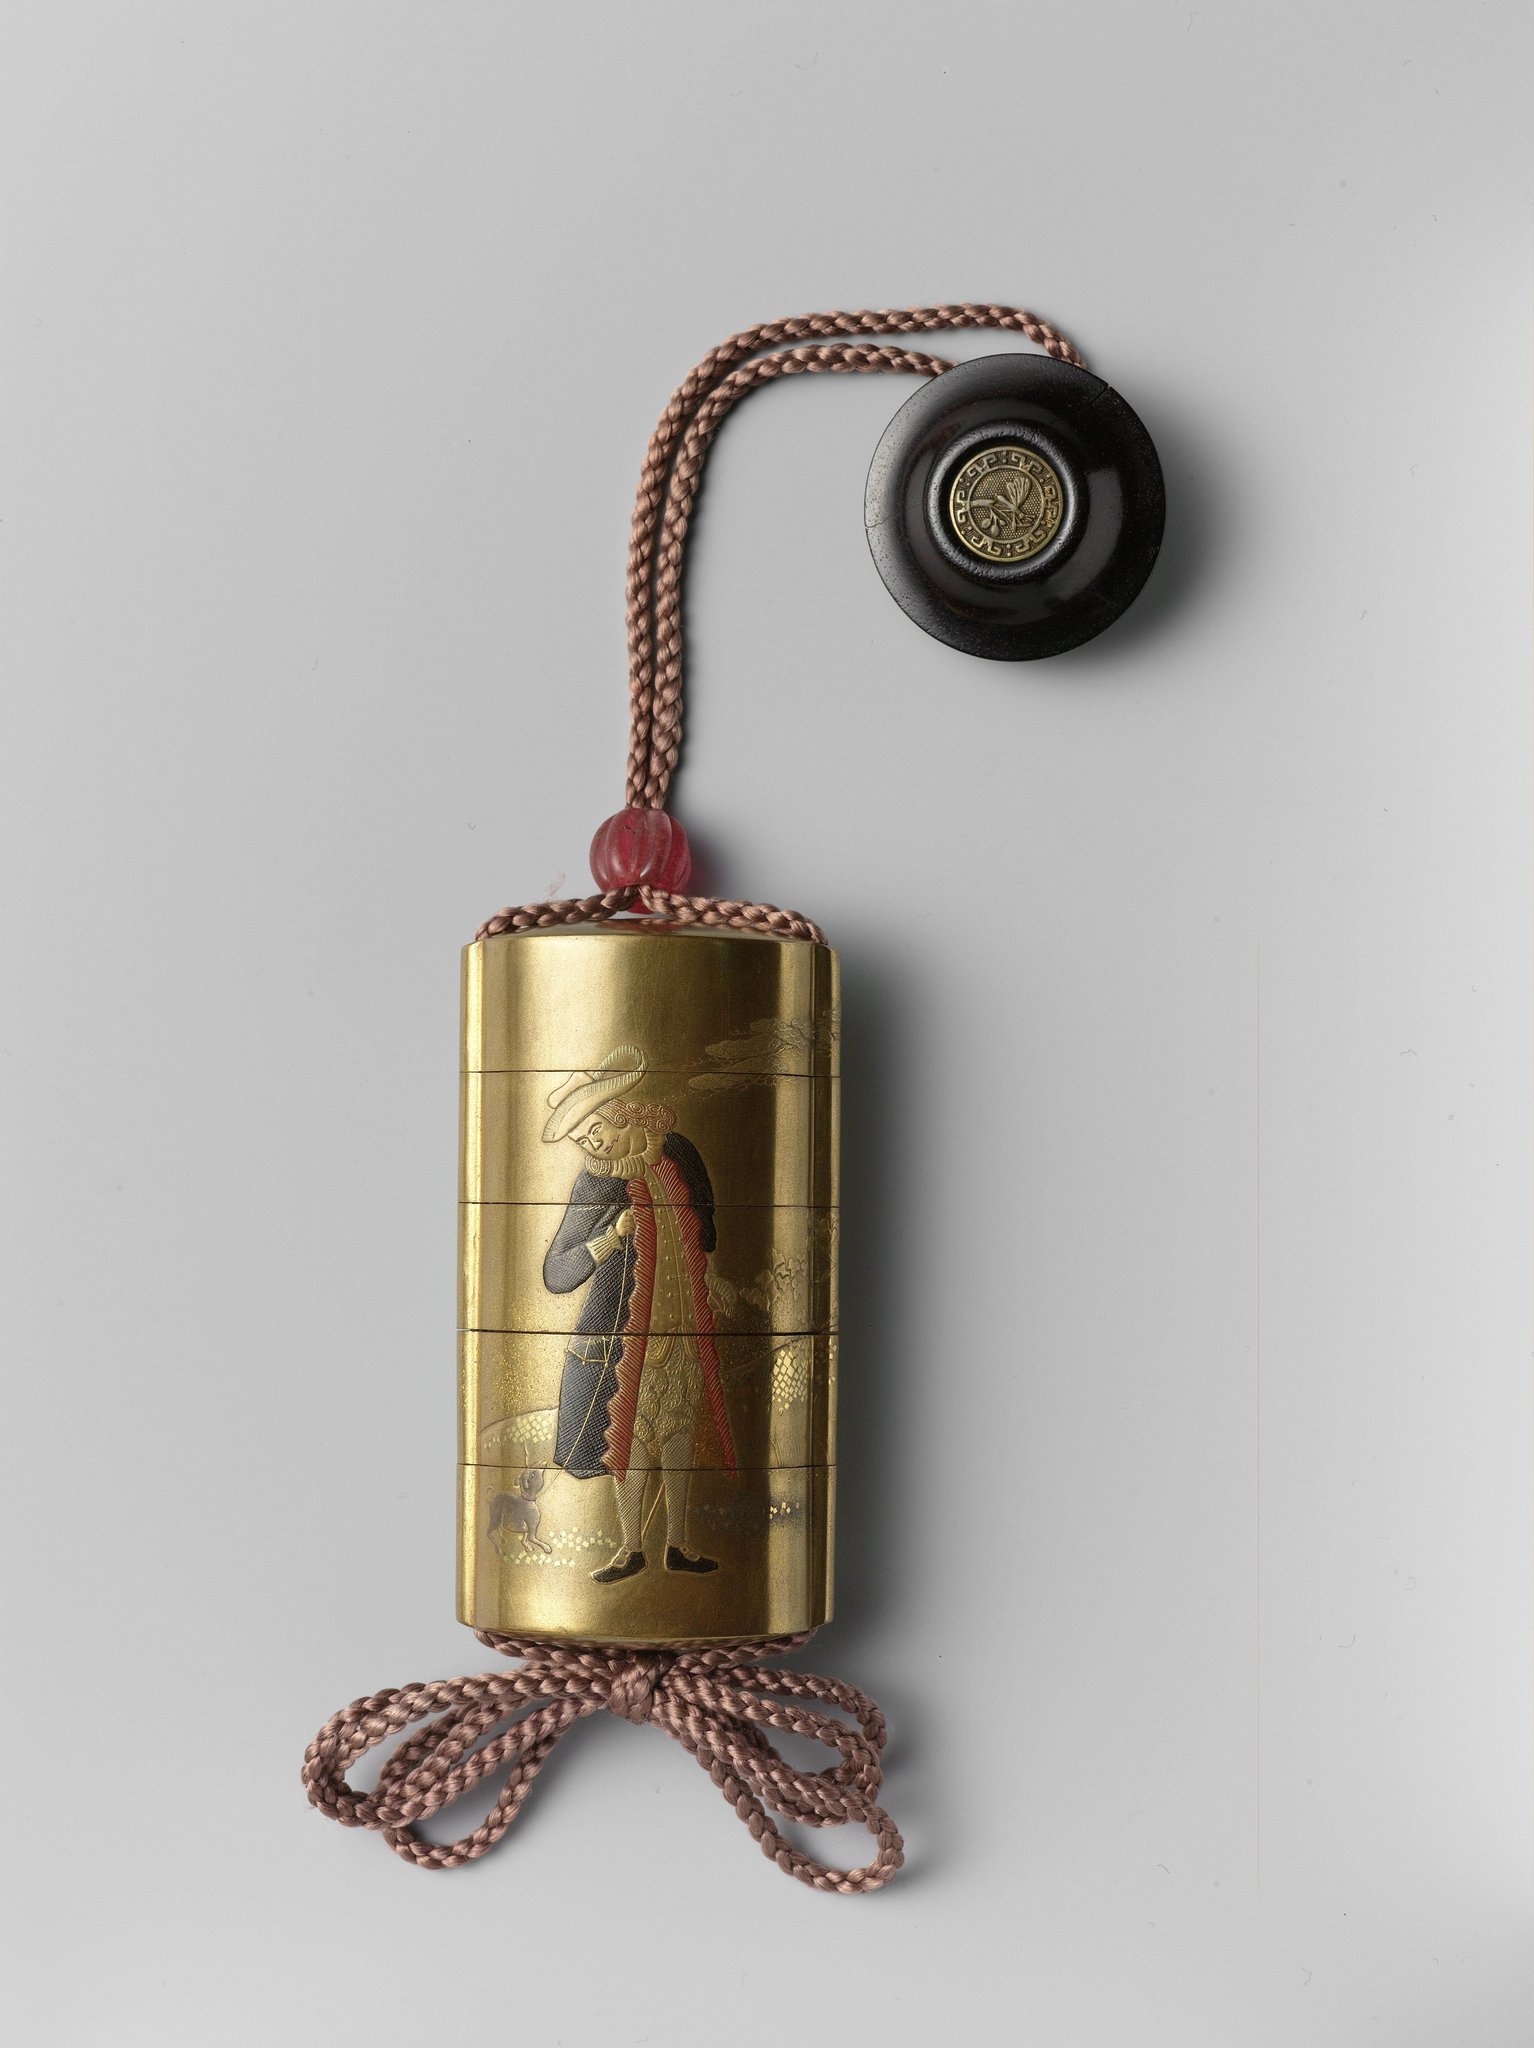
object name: inrō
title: Inro (seal case)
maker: Anonymous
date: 1775-1800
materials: lacquer, metal, textile, wood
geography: japan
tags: standing figure, clothes, costume (+ men's clothes), walking the dog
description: Inro, bestaande uit 5 delen, met knoop (ojime) en gordelknoop (netsuke). Op de ene kant een Hollandse koopman, op de andere kant een Portugees. Het koord is niet authentiek. Vijf doosjes bij elkaar gehouden door een koord.